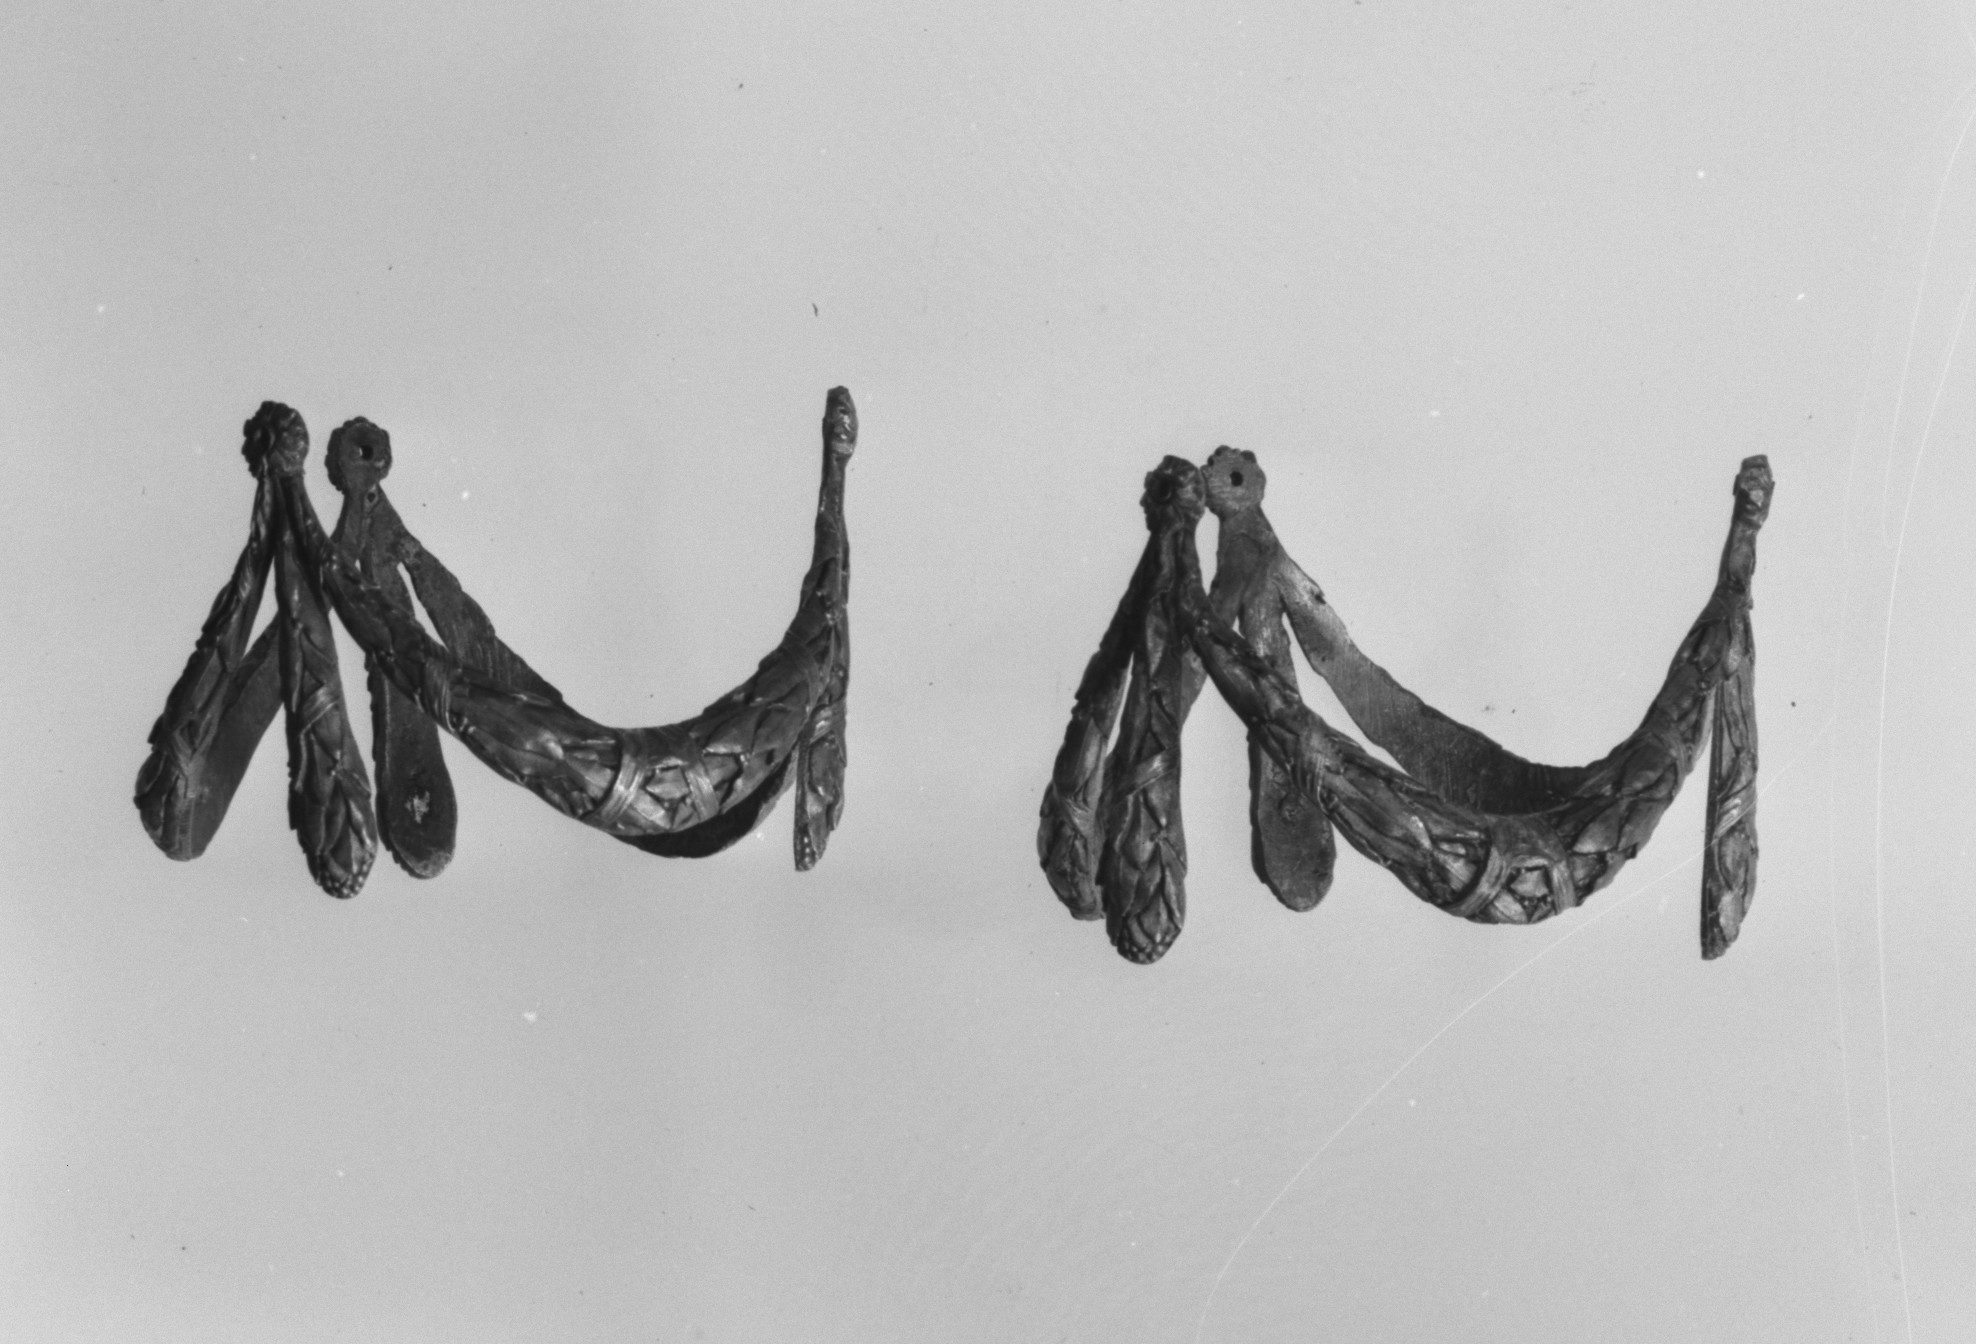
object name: ornament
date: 1701-1800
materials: gilt bronze